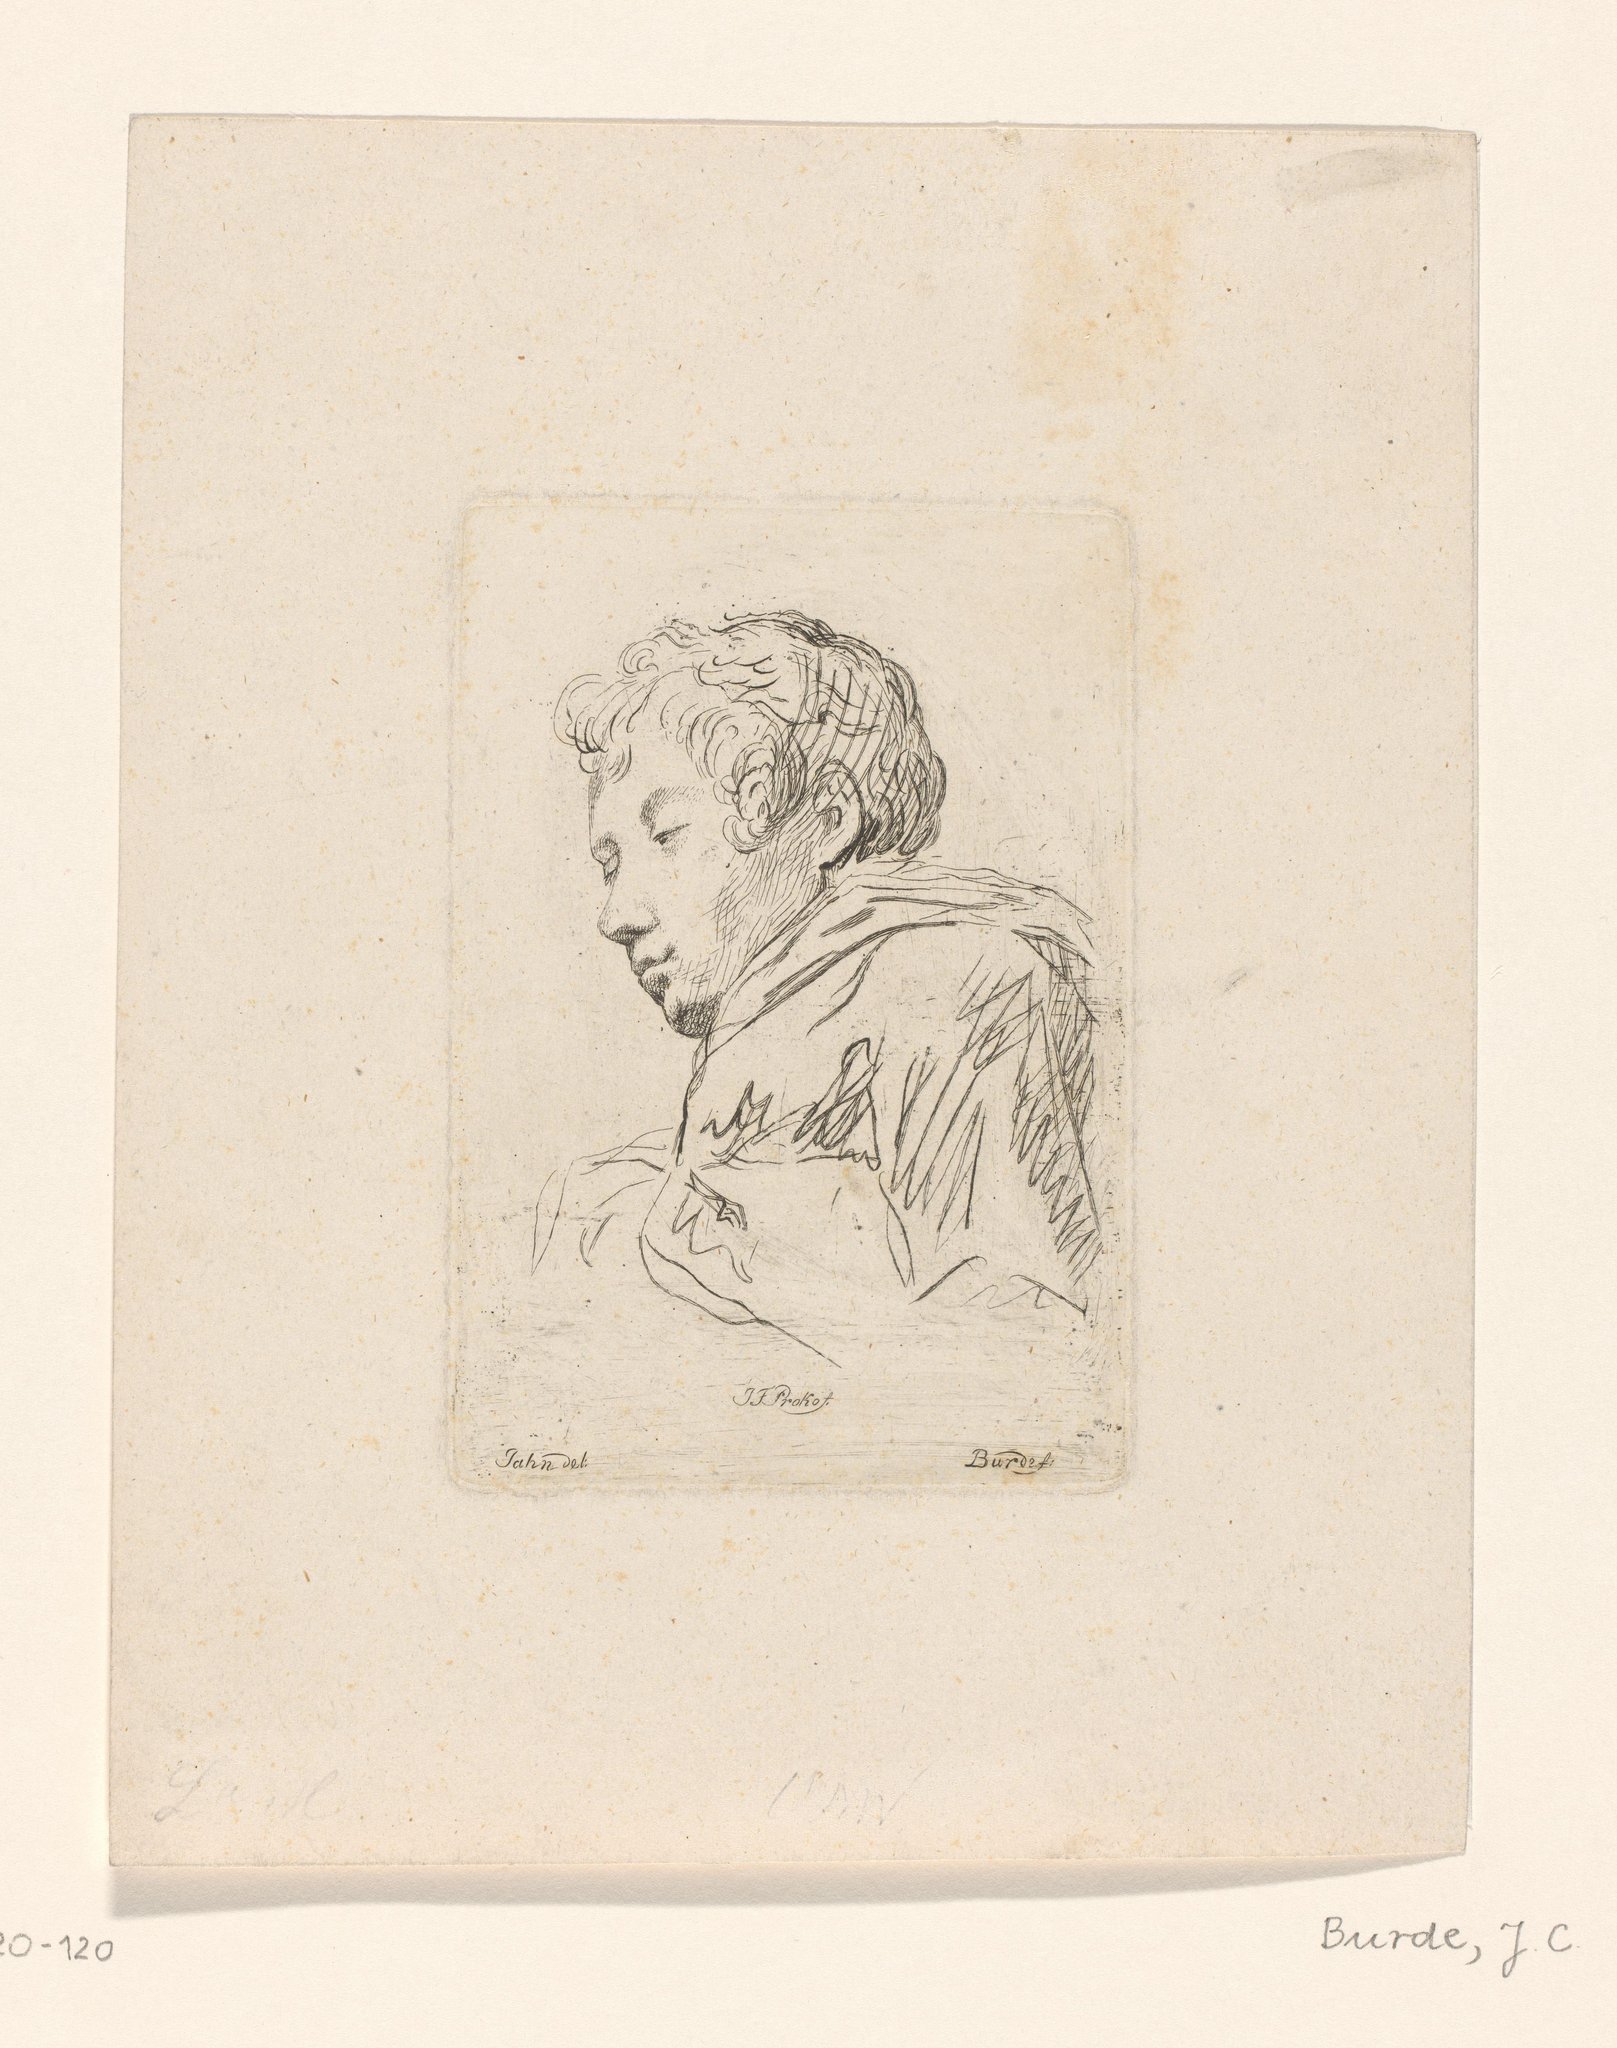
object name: print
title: Portret van de beeldhouwer J.F. Prokof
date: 1805-1820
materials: paper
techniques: etching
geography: prague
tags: portrait, self-portrait of sculptor, historical persons, portrait, self-portrait of artist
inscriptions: collector's mark: Lugt 2760, collector's mark: Lugt 2228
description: Schetsmatig weergegeven portretbuste van de beeldhouwer J.F. Prokof.